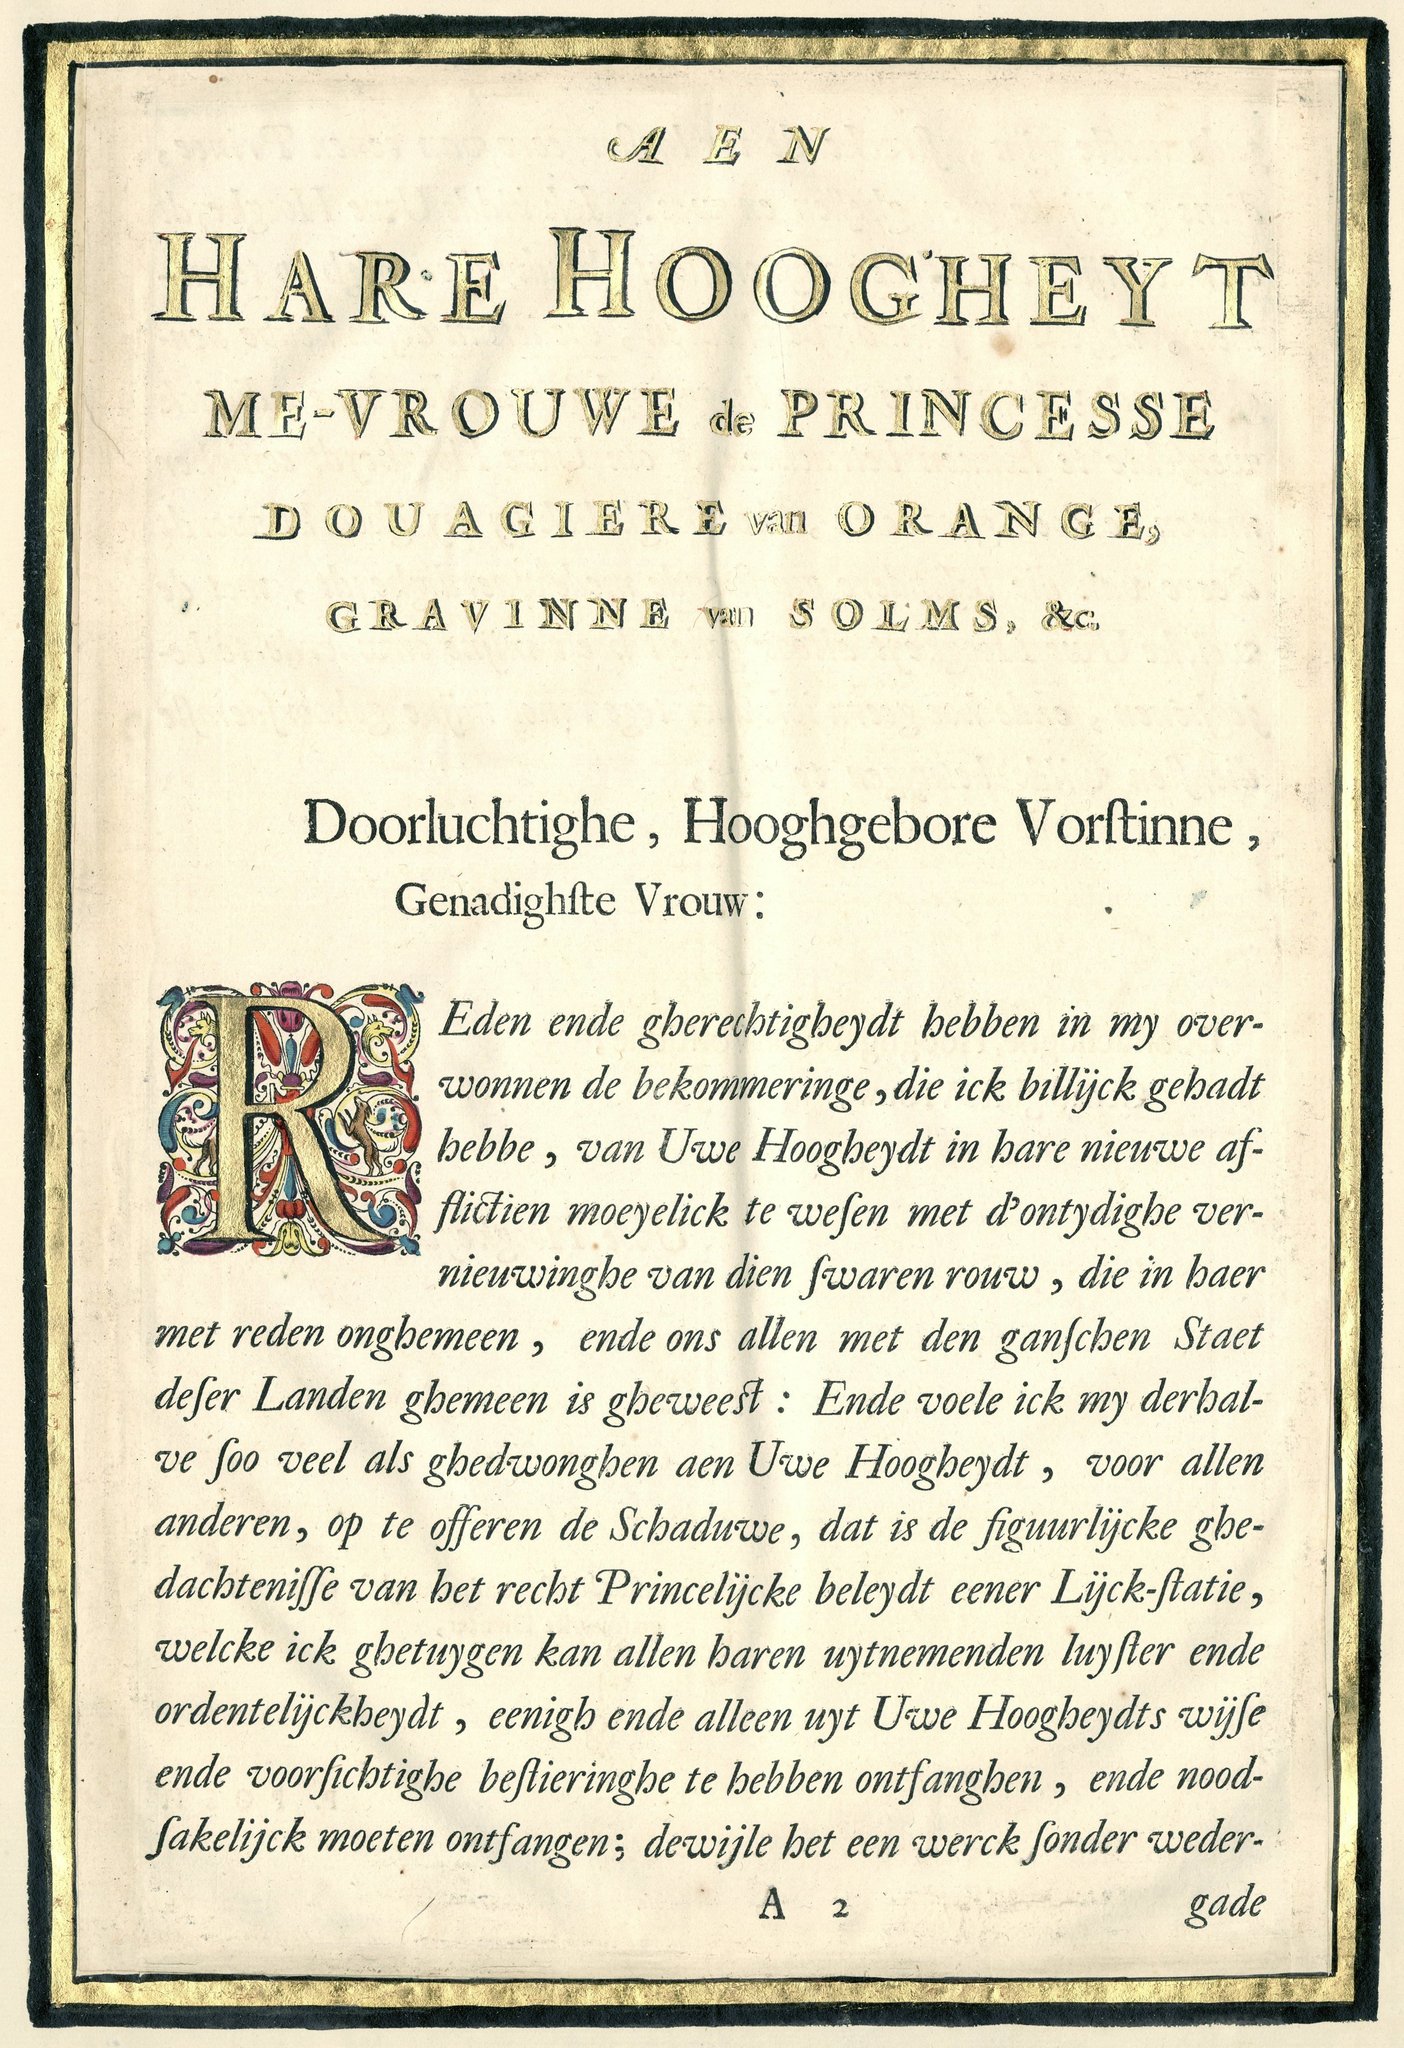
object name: book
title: De opdracht aan Amalia van Solms, de weduwe van Frederik Hendrik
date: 1651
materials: paint, paper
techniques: colour, letterpress printing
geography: amsterdam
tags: delft, frederick henry (prince of orange), amalia of solms-braunfels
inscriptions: date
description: De opdracht (voorzijde) aan Amalia van Solms, de weduwe van Frederik Hendrik. Met een versierde initiaal R. Blad uitgeknipt, versierd met goud en ingeplakt in de luxe editie uit ca.1755 van het boek 'Begraeffenisse van syne hoogheyt Frederick Henrick' van Pieter Post, uitgegeven te Amsterdam in 1651.